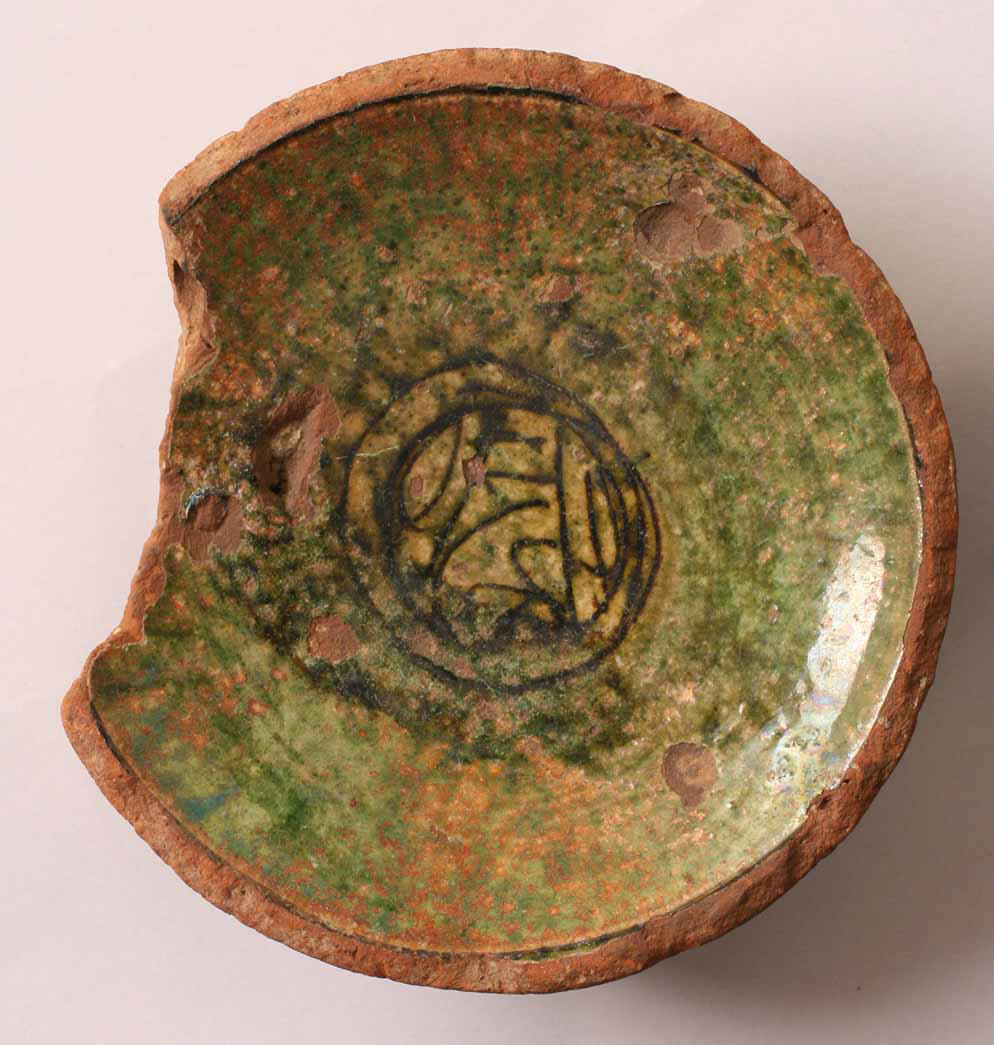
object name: fragment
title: Fragment of a Bowl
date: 1301-1500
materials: earthenware, glaze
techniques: coloring, incising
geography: egypt